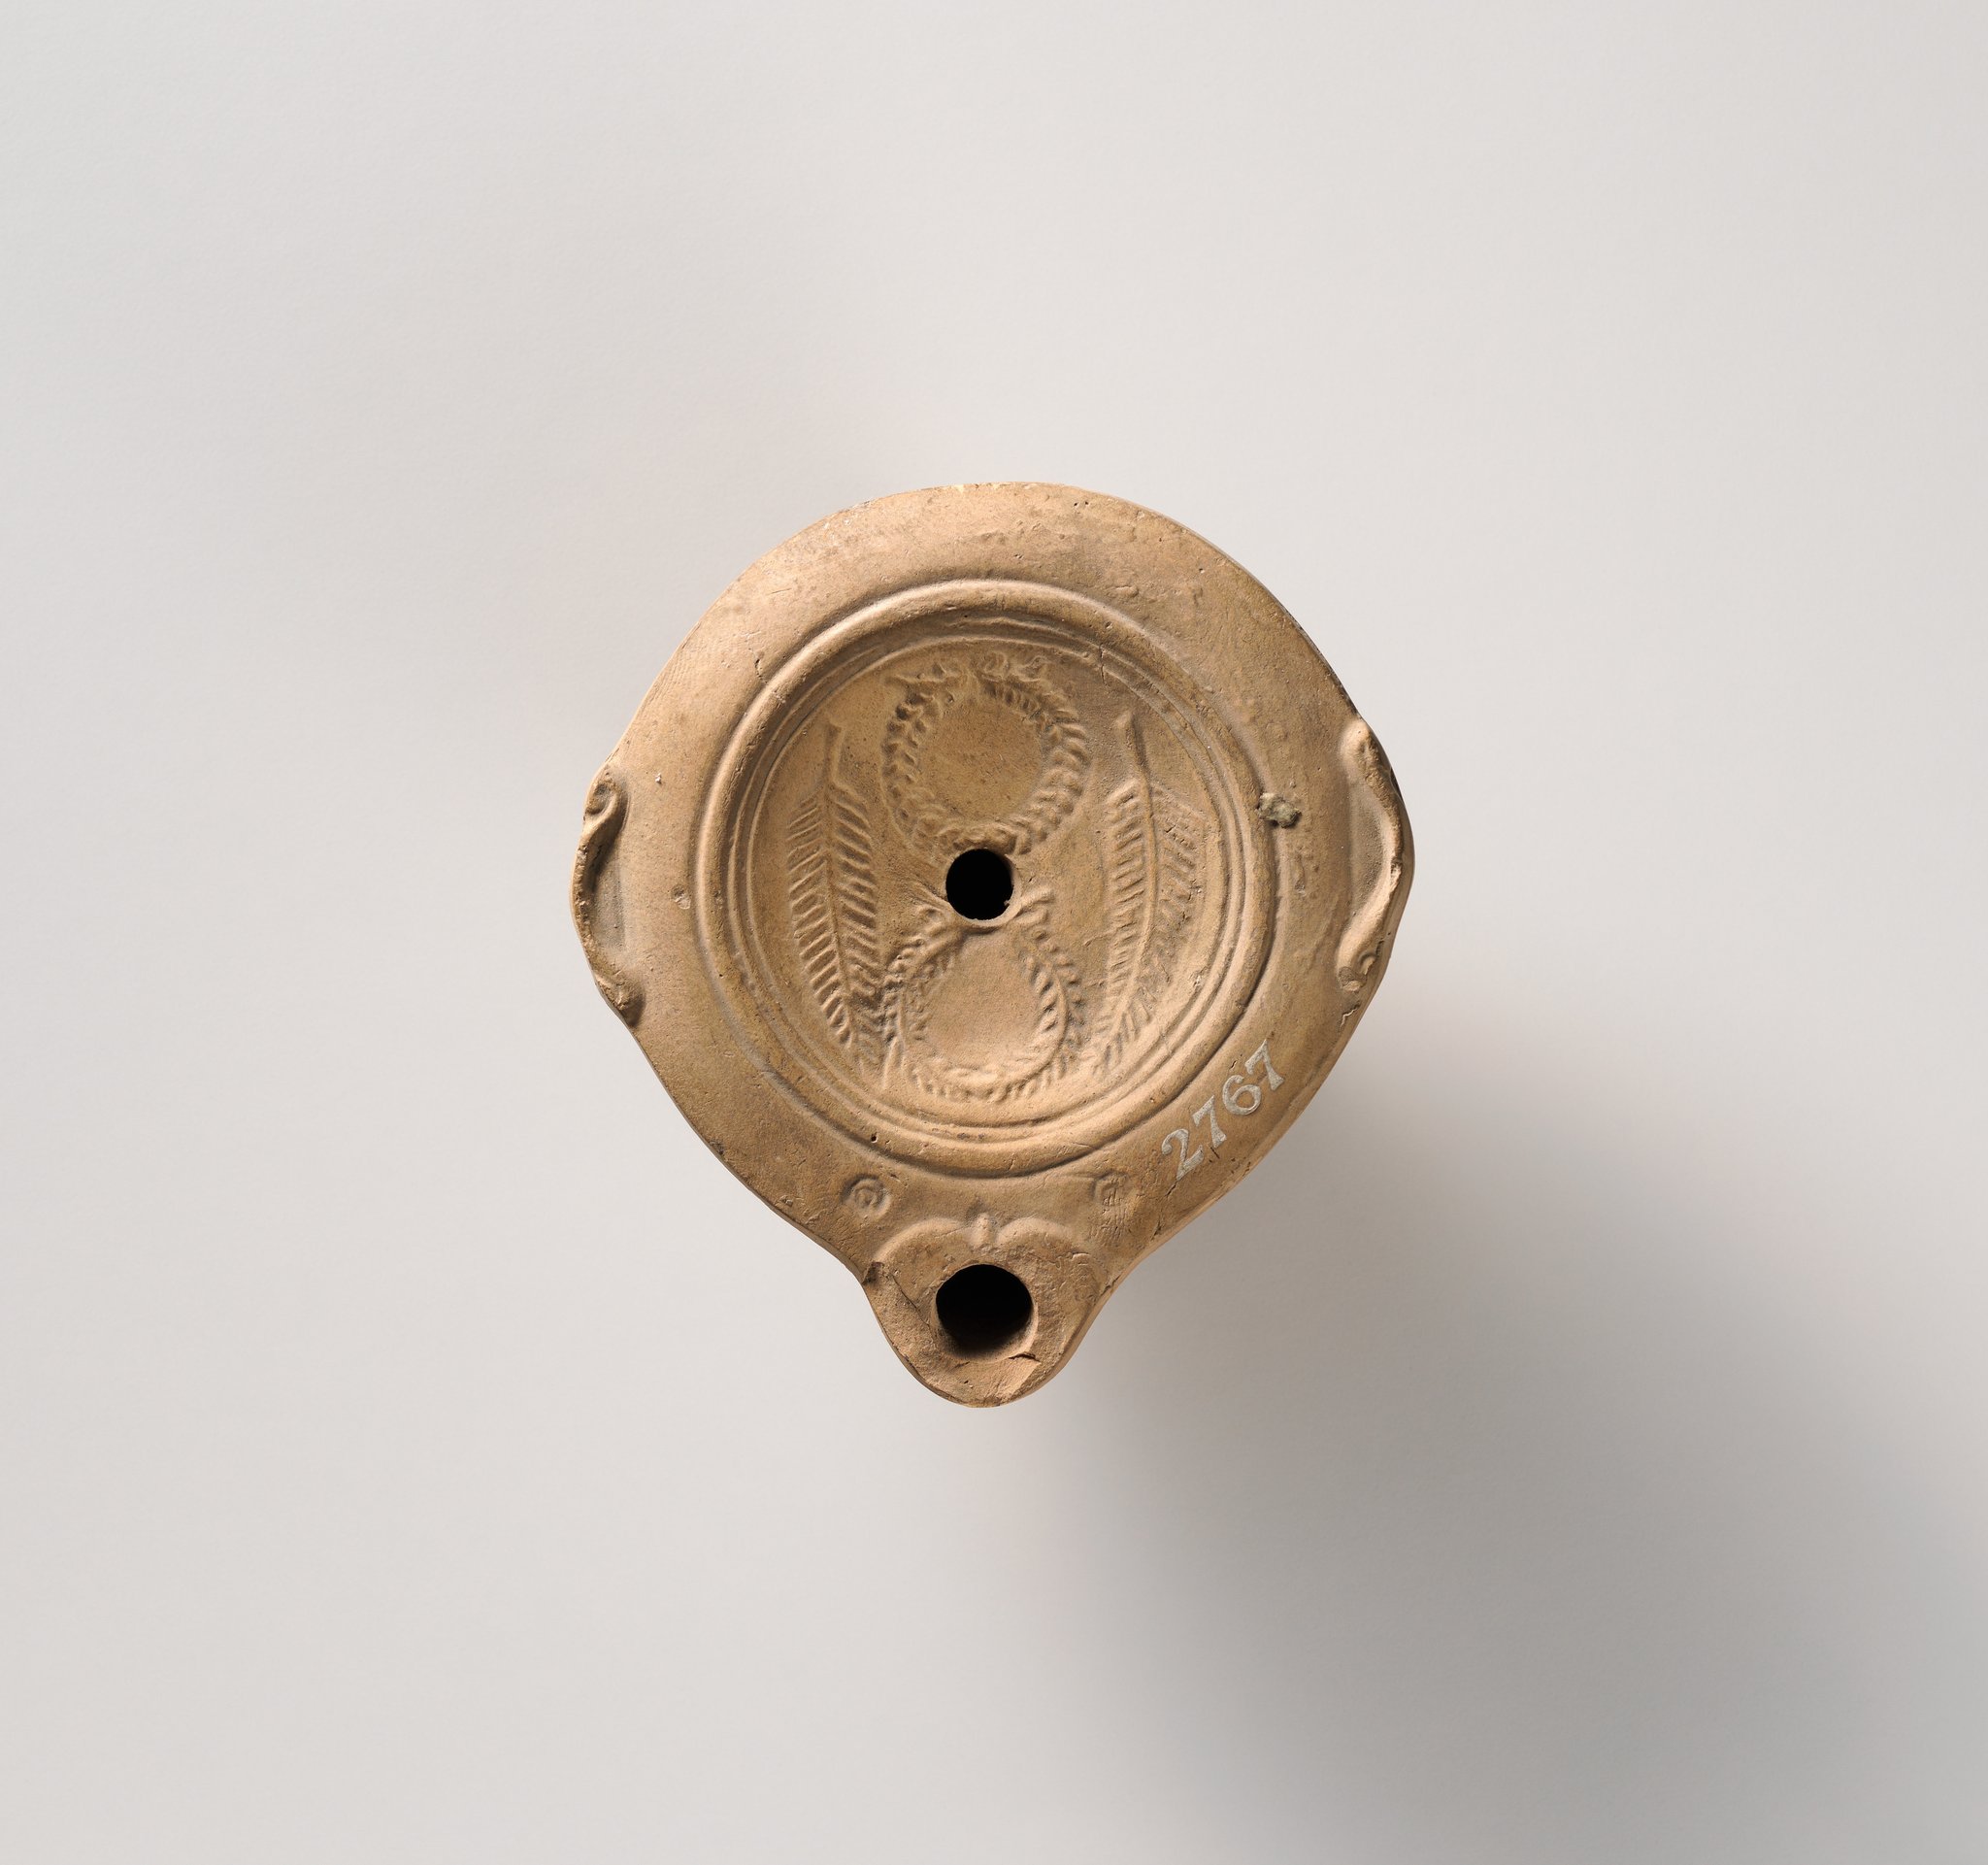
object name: lamp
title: Terracotta oil lamp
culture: roman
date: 101-200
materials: terracotta